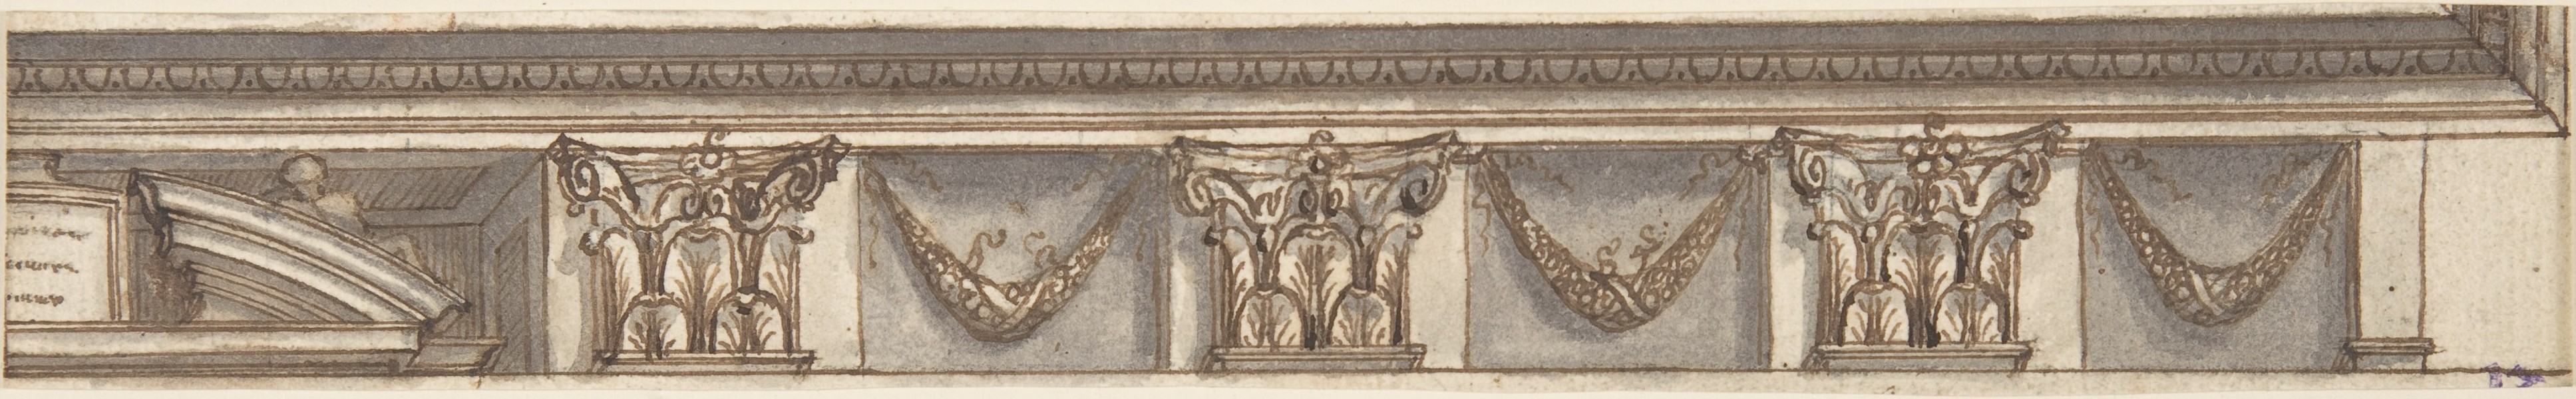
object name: drawing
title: Design for a Cornice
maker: anonymous, italian, 19th century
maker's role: artist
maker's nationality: italian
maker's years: 1800-1900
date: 1800-1900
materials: ink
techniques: pen, wash